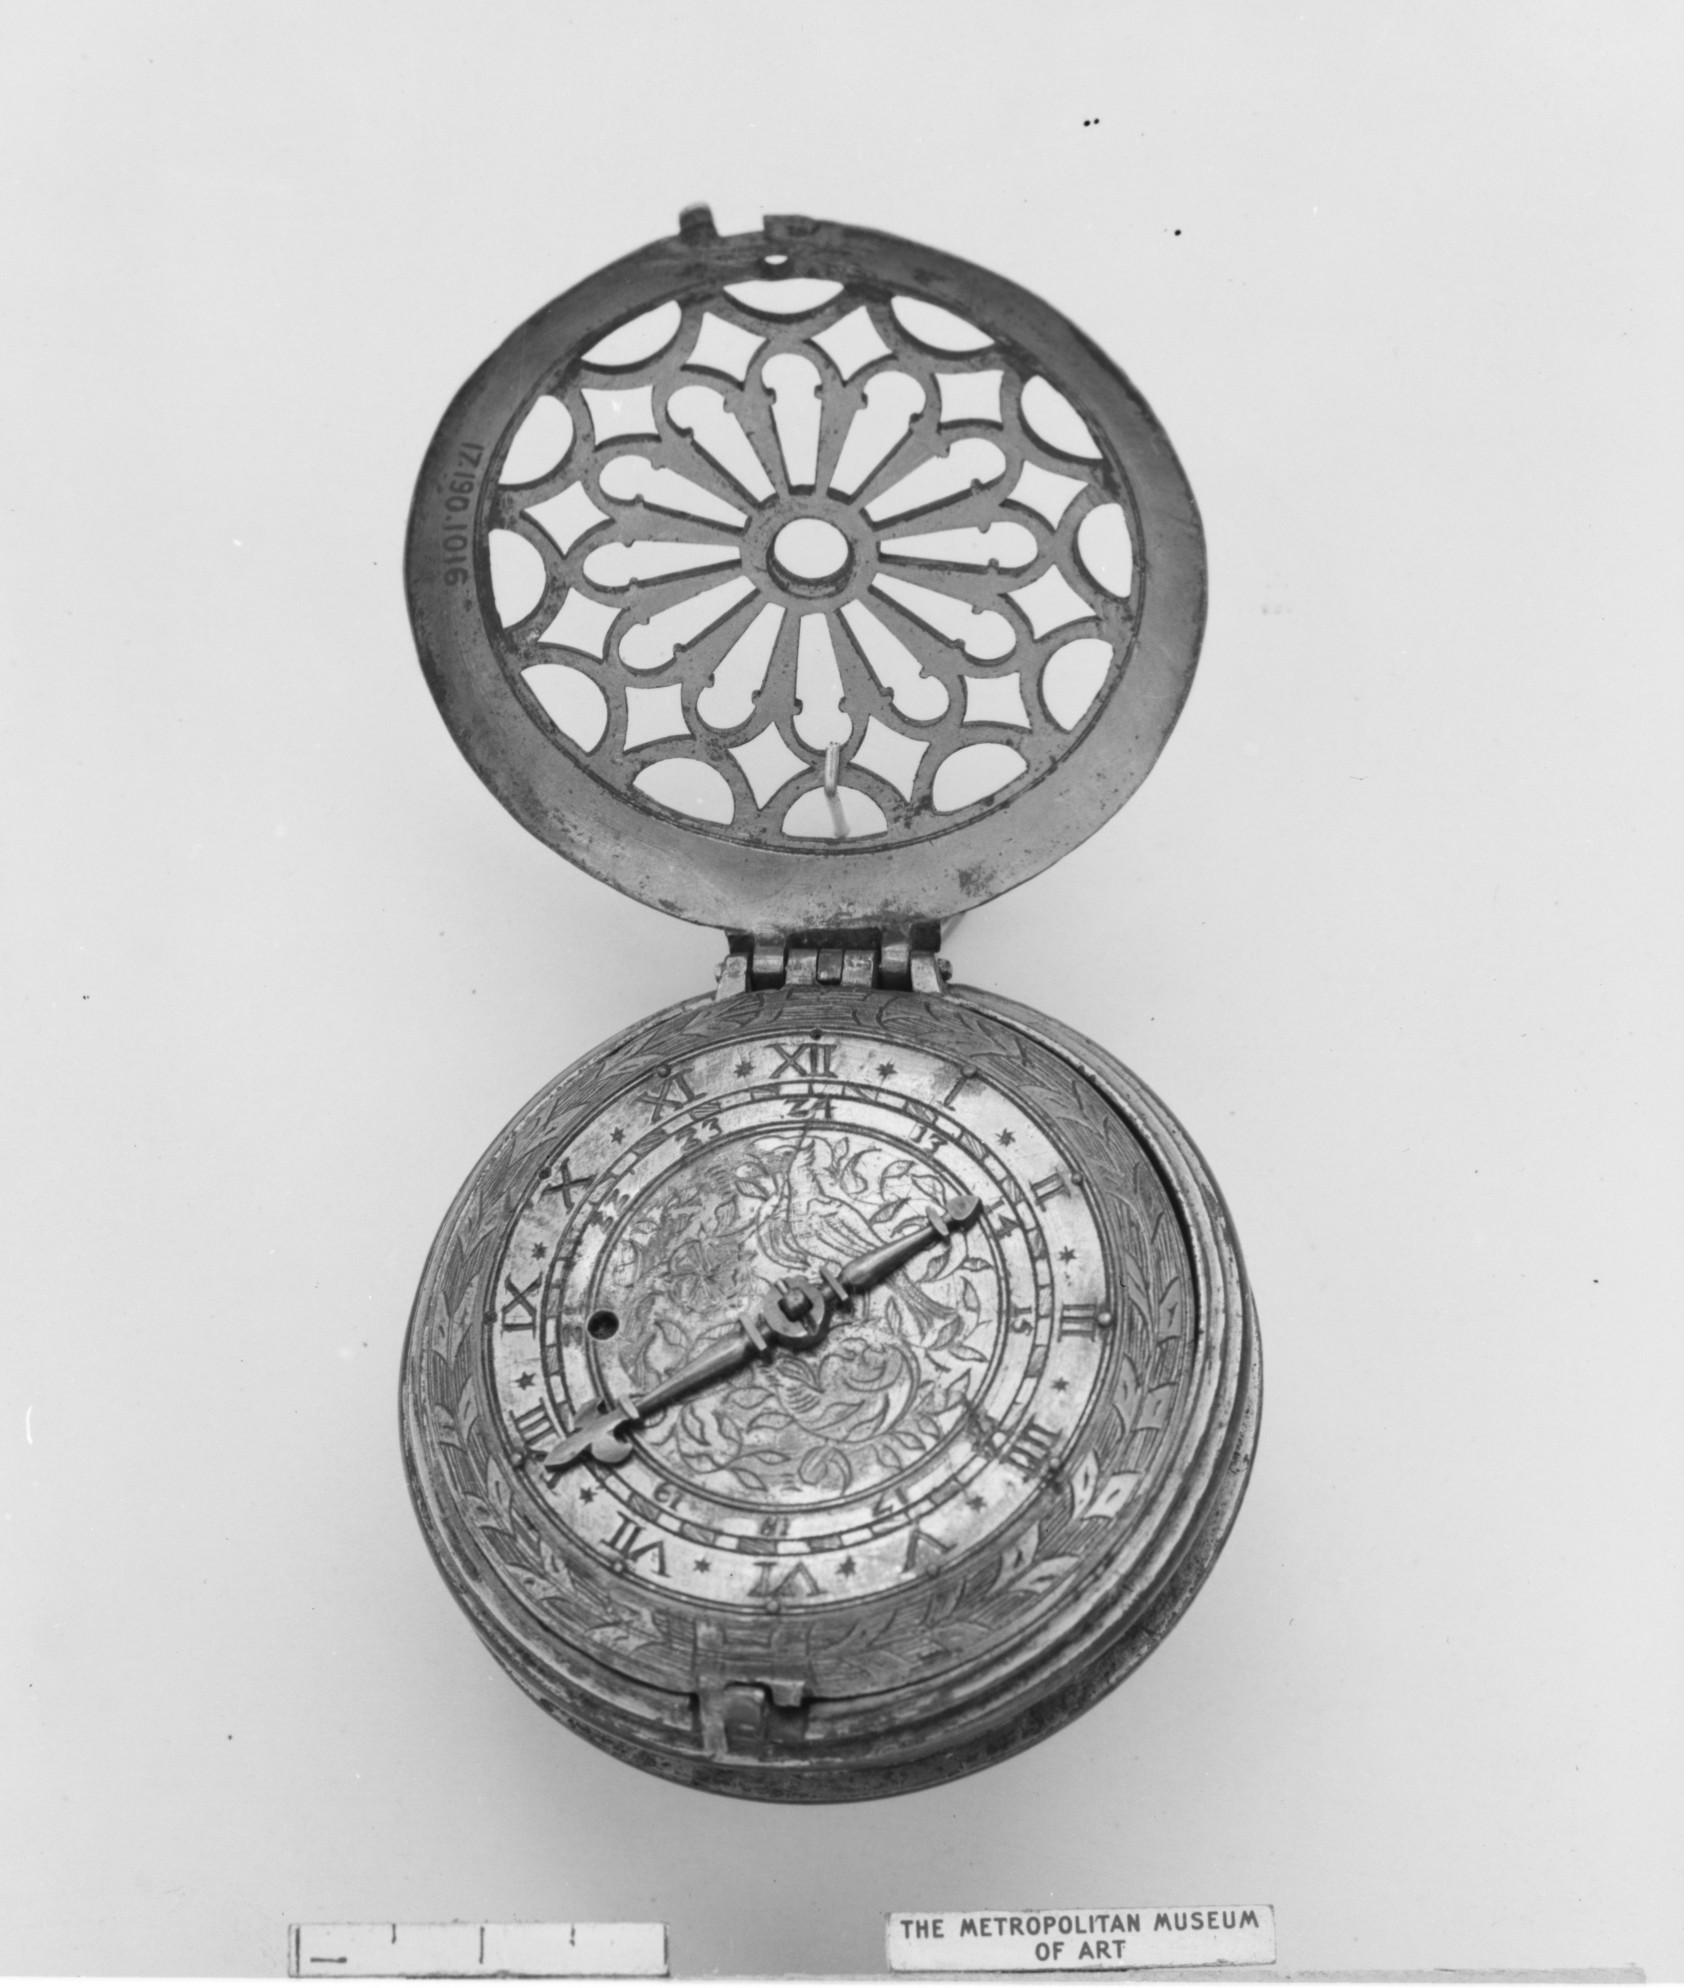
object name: watch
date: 1601-1700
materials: gilt copper, iron